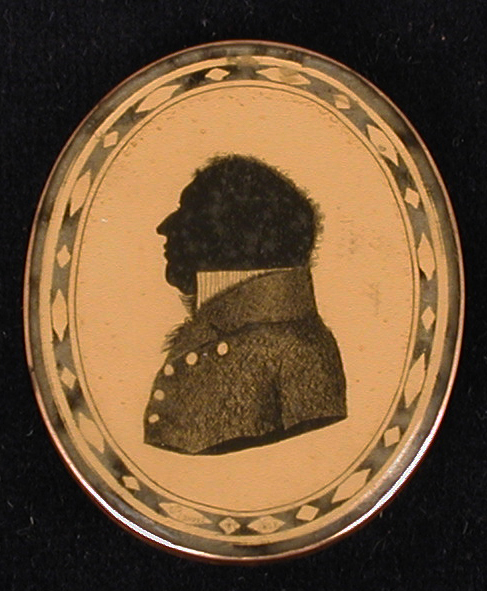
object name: medallion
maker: rauert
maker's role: maker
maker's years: 1750-1850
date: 1808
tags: men,profiles